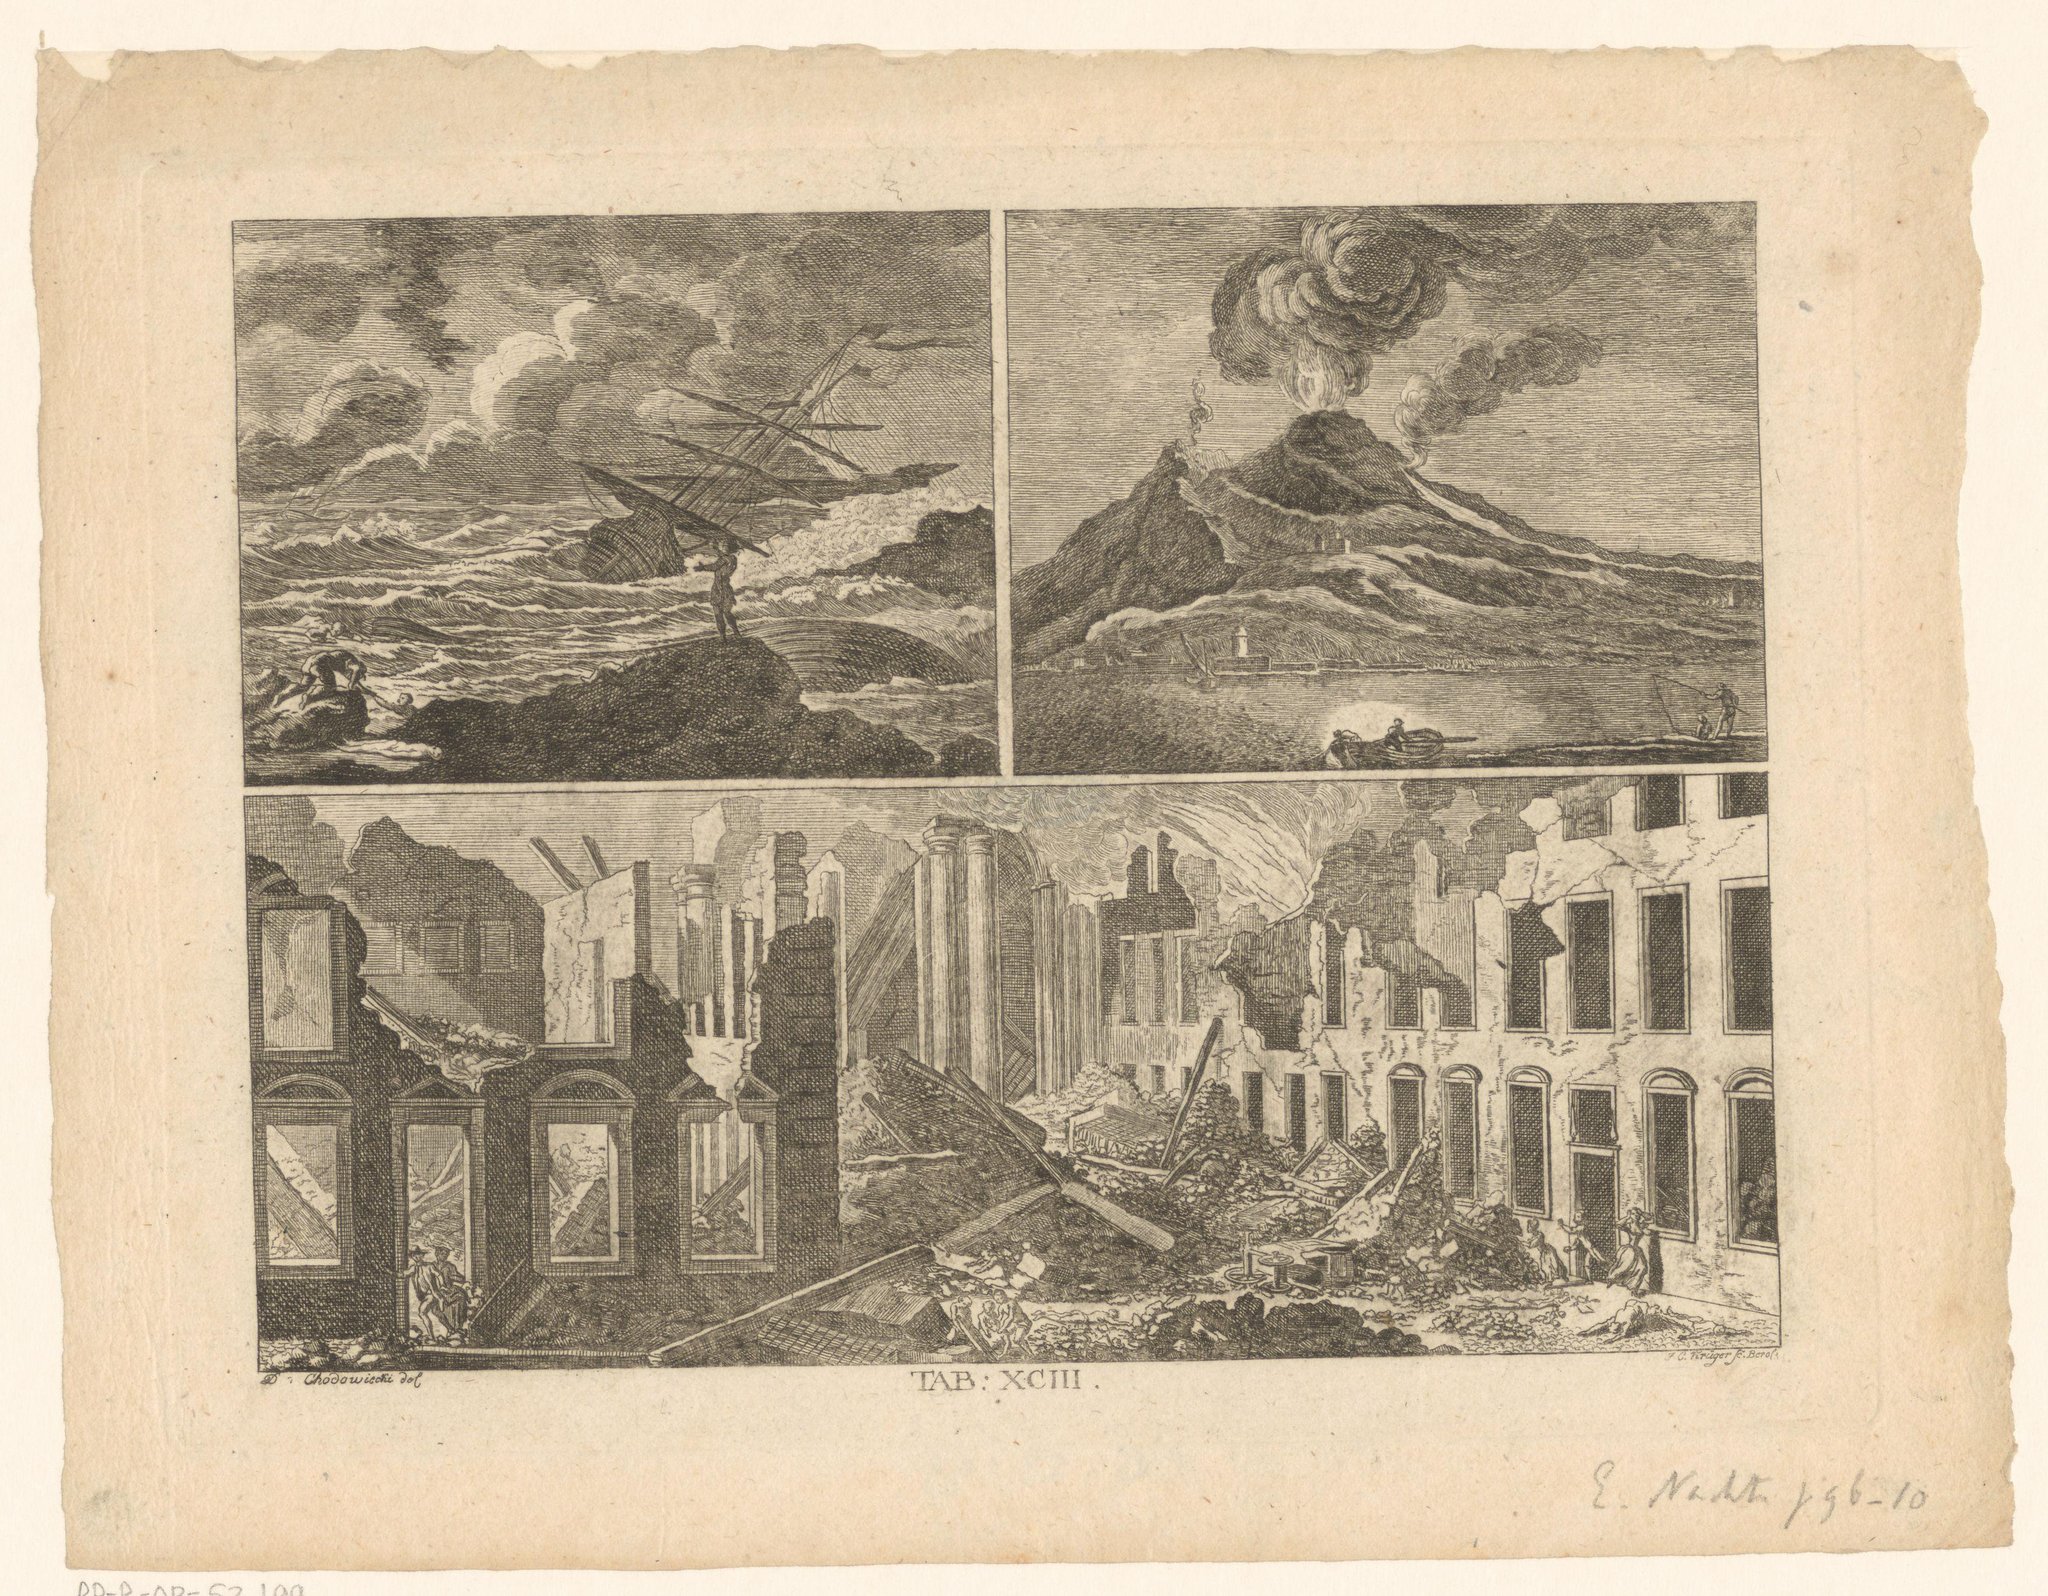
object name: book illustration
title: Drie voorstellingen met een schipbreuk op zee, uitbarstende vulkaan en een verwoeste stad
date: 1774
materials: paper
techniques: etching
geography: berlin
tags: shipping accident; sickness and death at sea, disorder, confusion, derangement, disorganization, chaos, devastated, ruined place or city (~ warfare), eruption (of volcano)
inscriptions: collector's mark: Lugt 2228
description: Prent uit: Basedow, Johann Bernhard. Kupfersammlung zu J.B. Basedows Elementarwerke für die Jugend und ihre Freunde (...). Berlijn en Dessau: s.n., 1774.